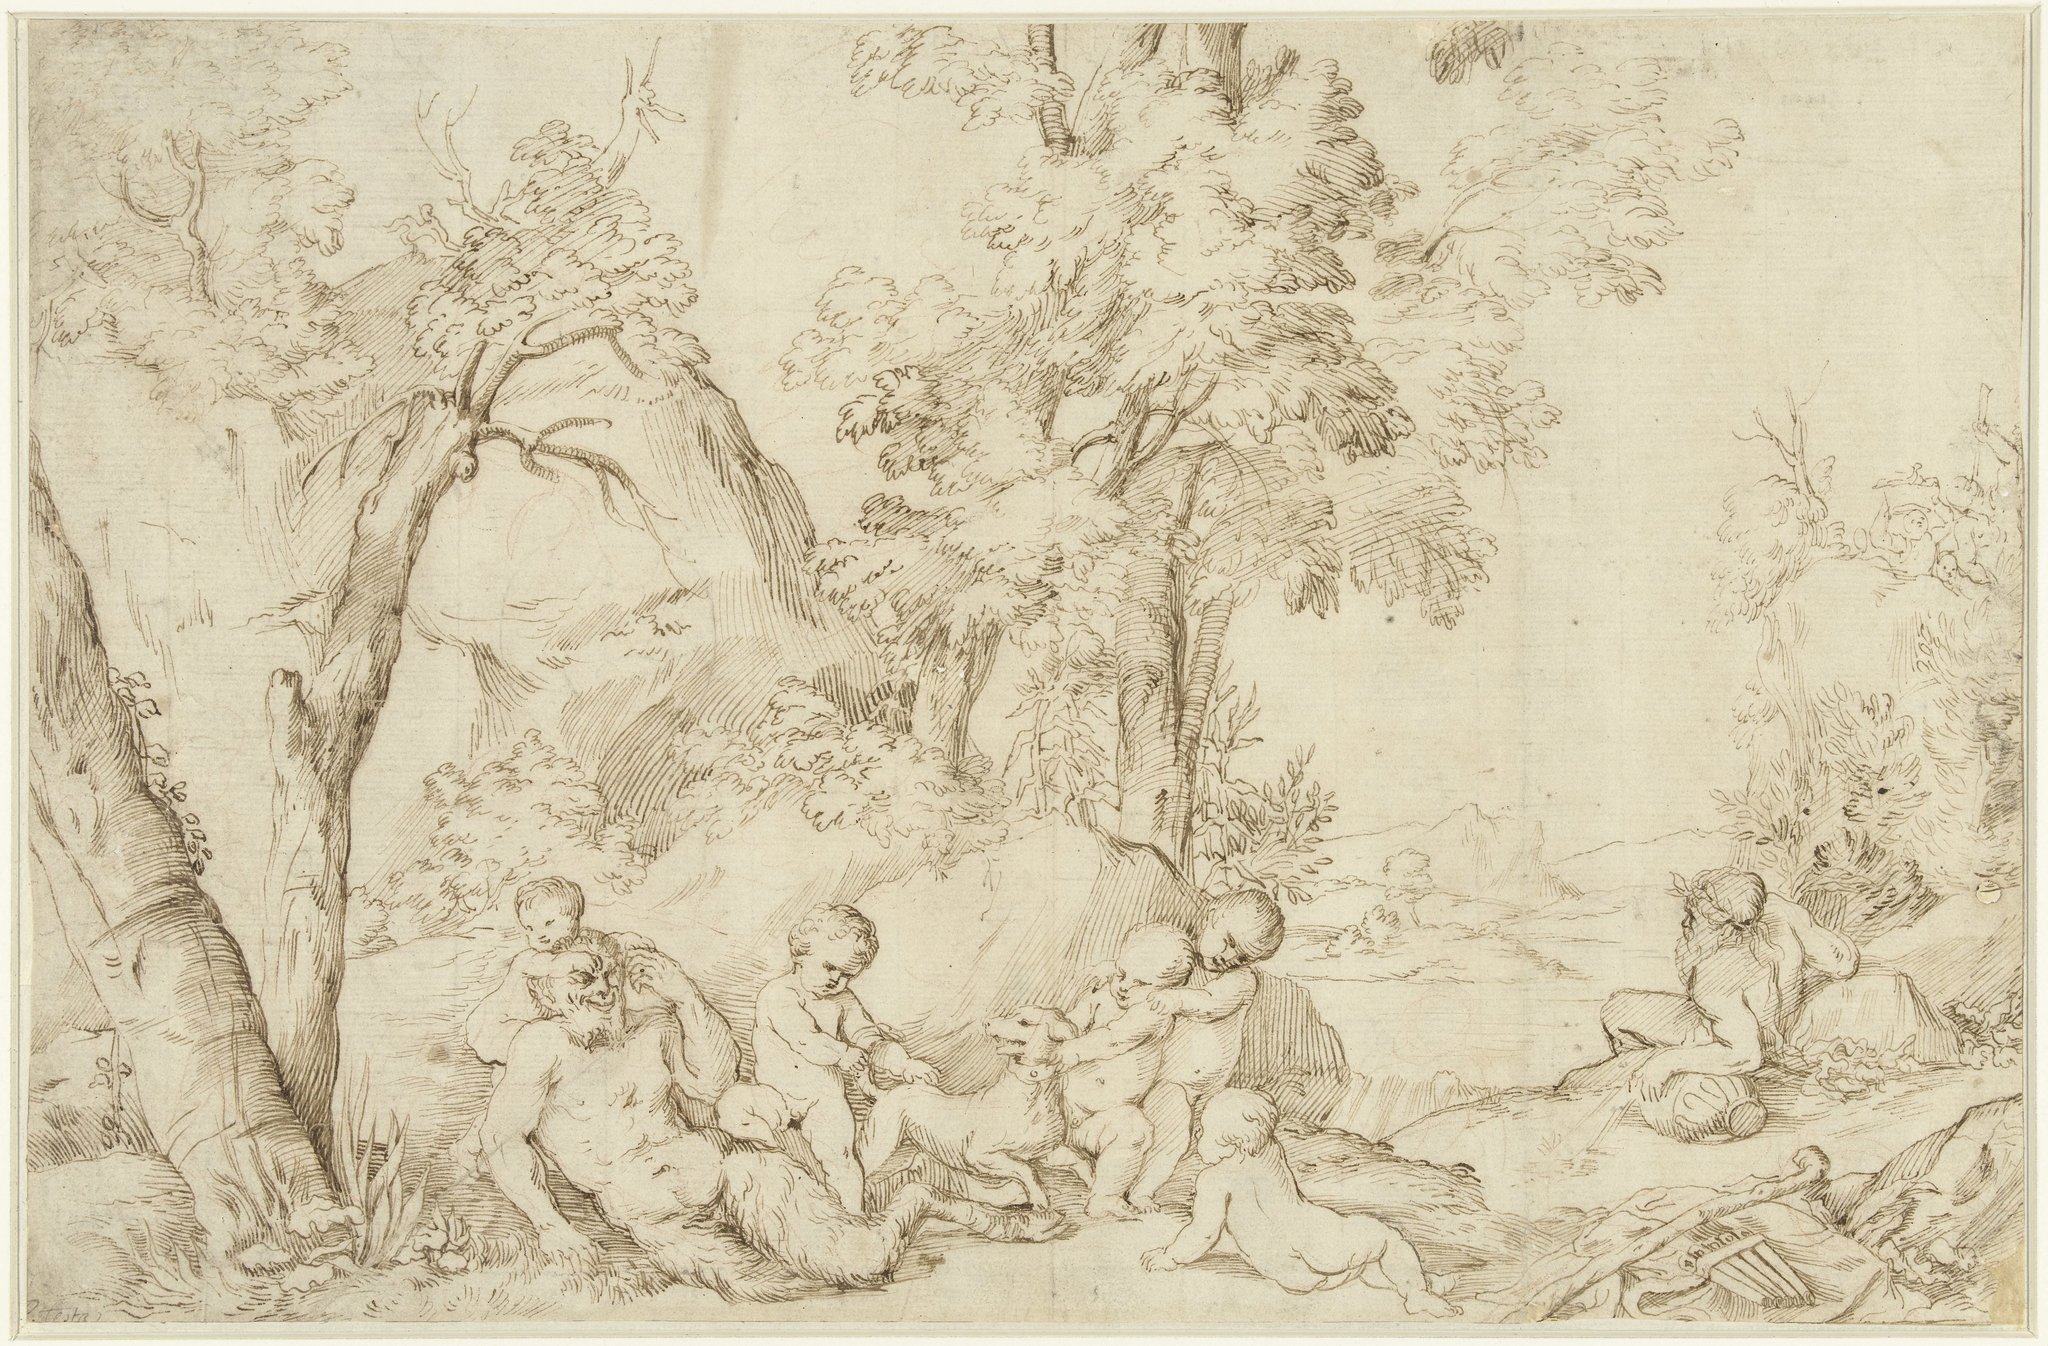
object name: drawing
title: Landschap met sater en putti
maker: pietro testa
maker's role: draughtsman, painter, print maker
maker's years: 1611-1650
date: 1622-1650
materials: ink, paper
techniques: pen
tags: landscapes in the temperate zone, satyr(s) (in general), cupids: 'amores', 'amoretti', 'putti'